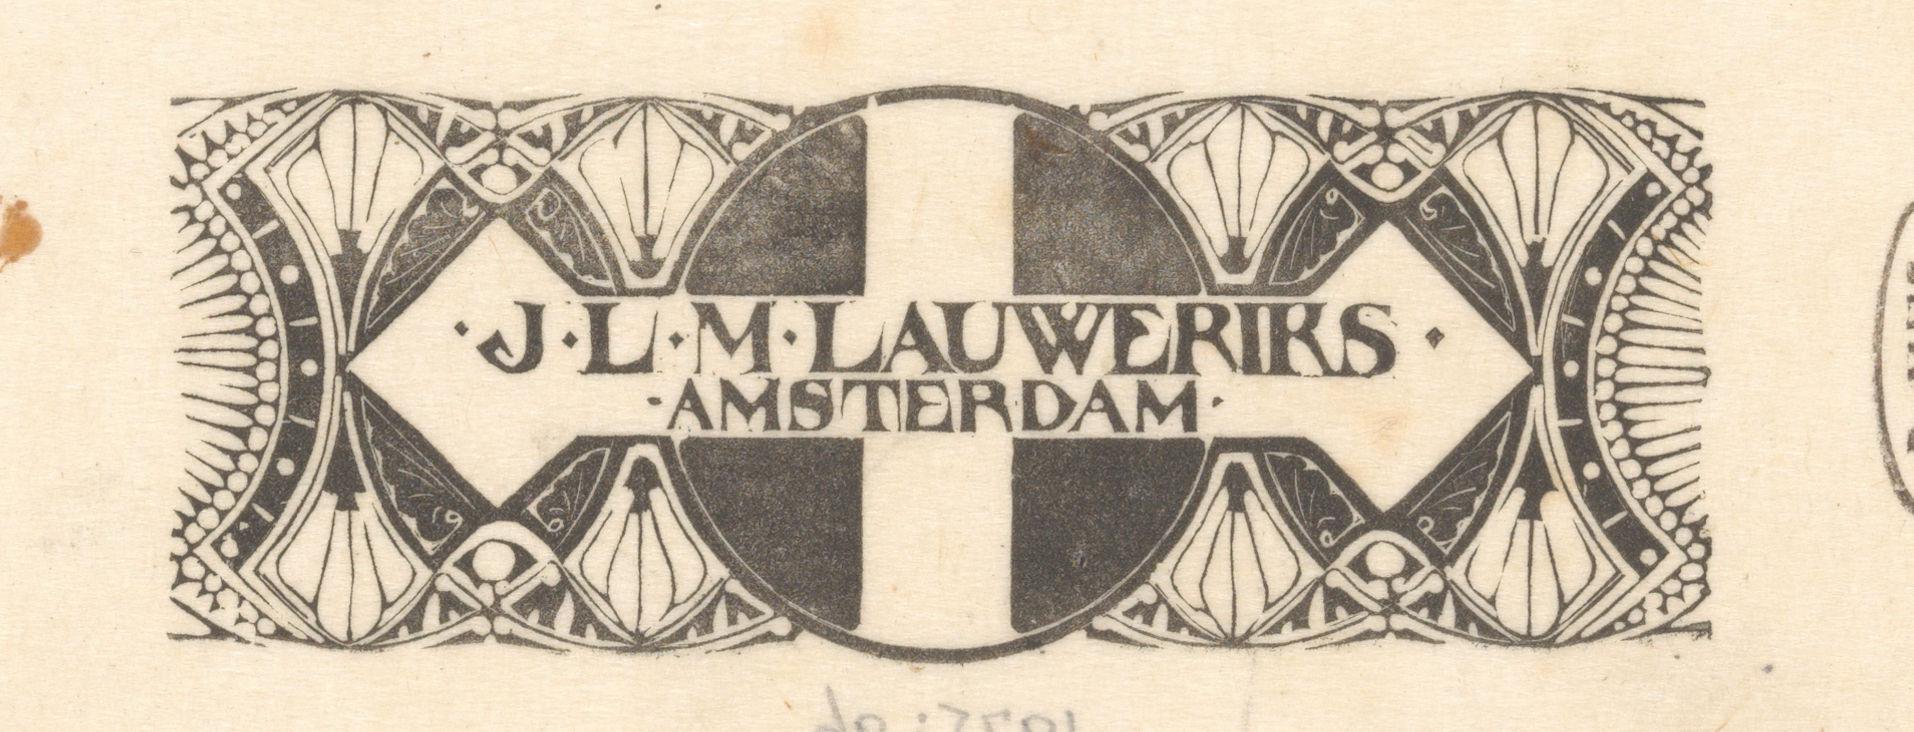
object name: visiting card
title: Visitekaartje van Mathieu Lauweriks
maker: mathieu lauweriks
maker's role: designer, draughtsman, print maker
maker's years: 1864-1932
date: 1897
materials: paper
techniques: woodcut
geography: amsterdam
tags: amsterdam, print maker, draughtsman, designer, mathieu lauweriks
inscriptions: collector's mark: Lugt 2228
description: Visitekaartje met in het midden de tekst 'J.L.M. Lauweriks Amsterdam'.